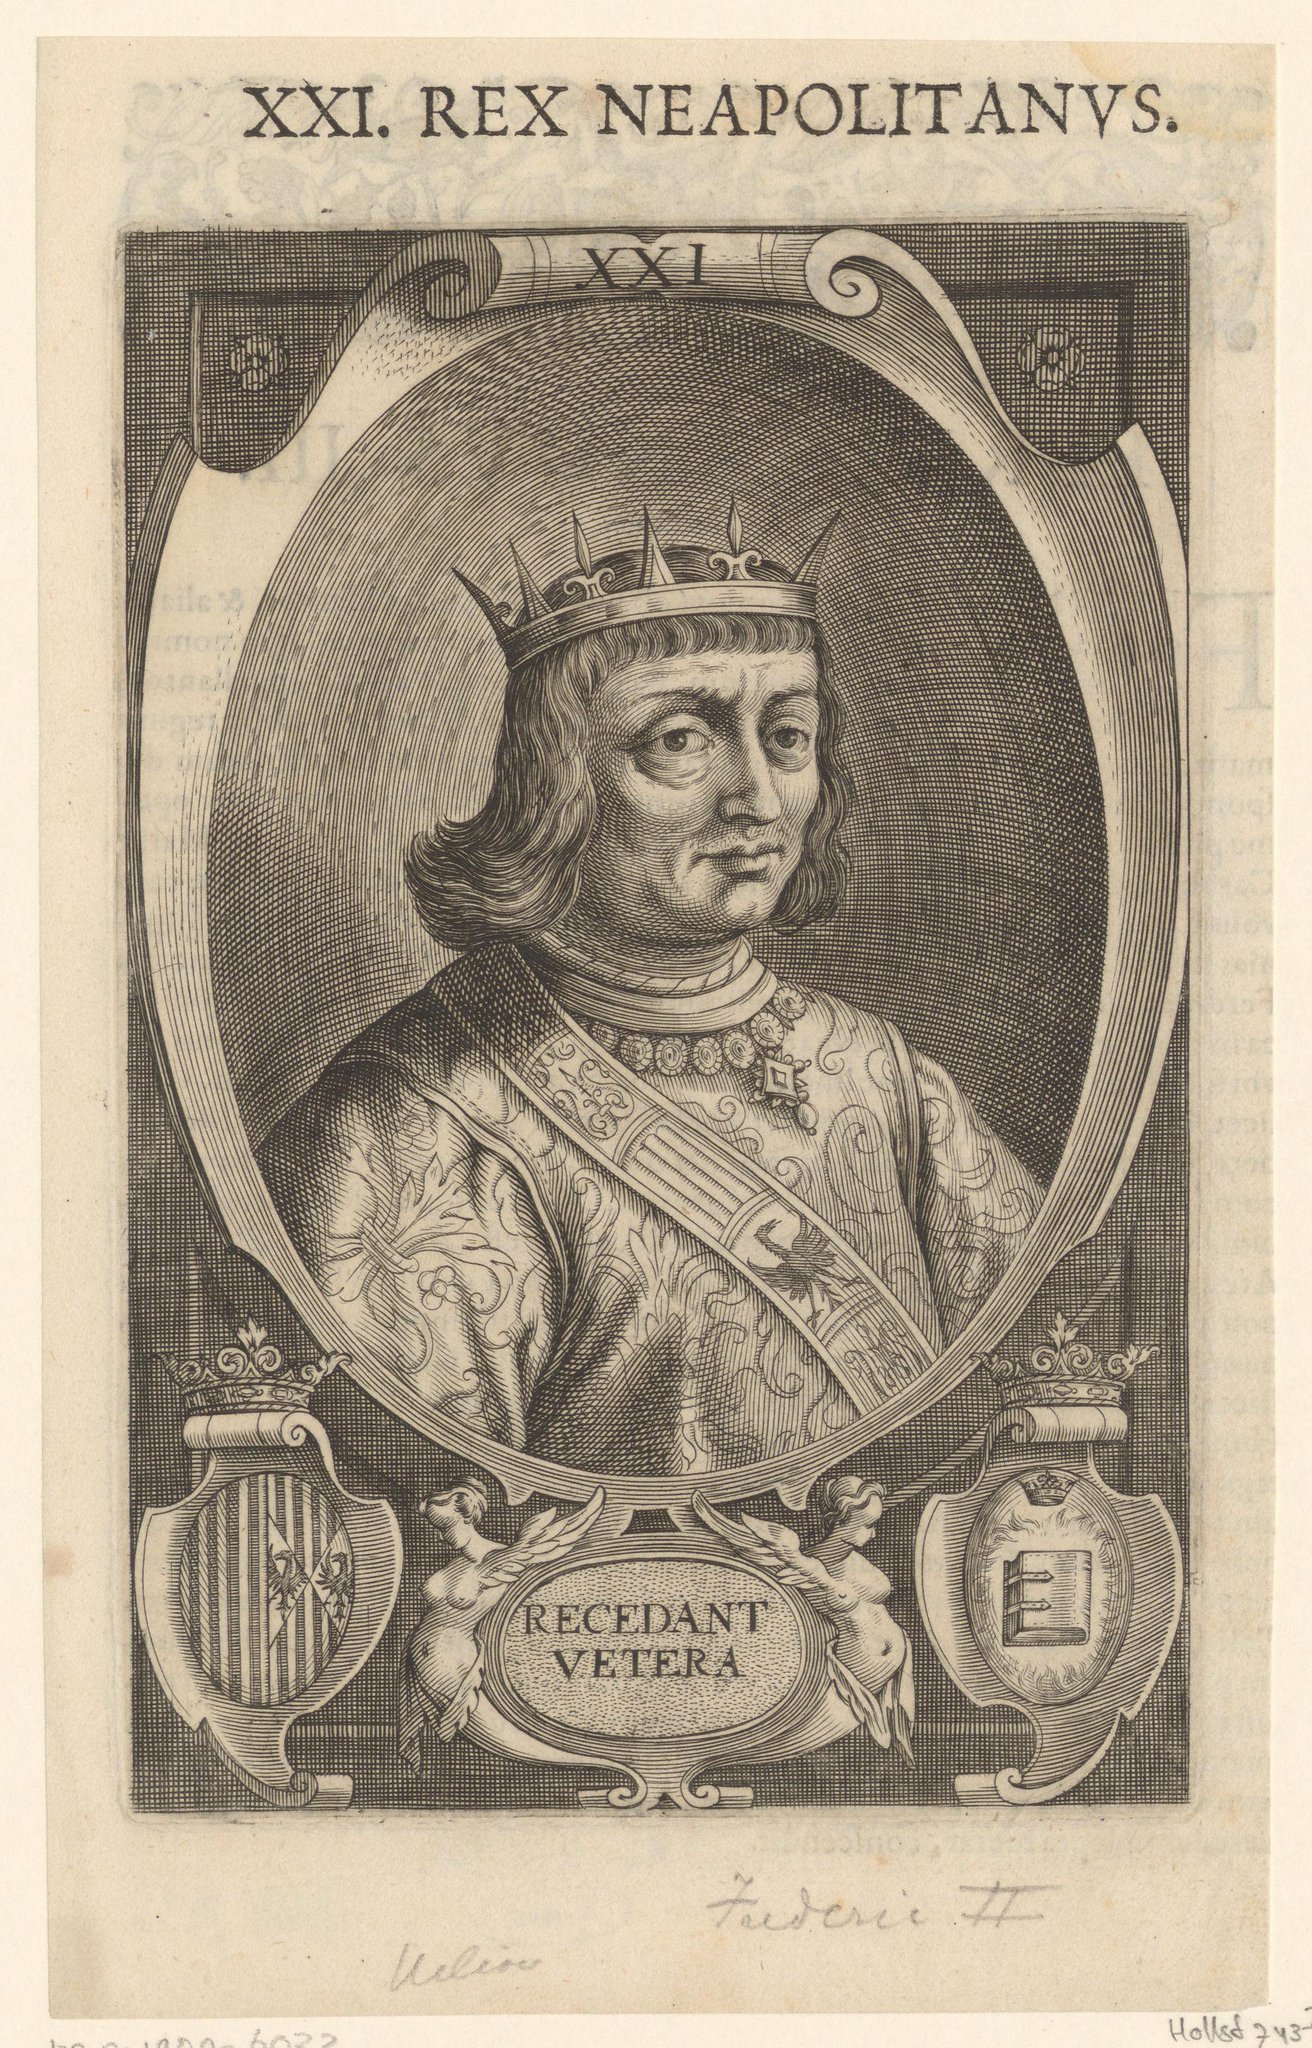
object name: book illustration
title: Portret van Frederik IV, koning van Napels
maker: lucas kilian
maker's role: draughtsman, print maker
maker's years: 1579-1637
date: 1589-1624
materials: paper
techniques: engraving, etching, letterpress printing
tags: naples, historical persons, king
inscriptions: collector's mark: Lugt 2228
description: Deze prent is gebruikt in: Mazzella, Scipione, Kilian, Lucas en Custos, Dominicus. Der Neapolitanische Koenige Leben und Bildnisse (...). Augsburg: Lucas Kilian, 1624.